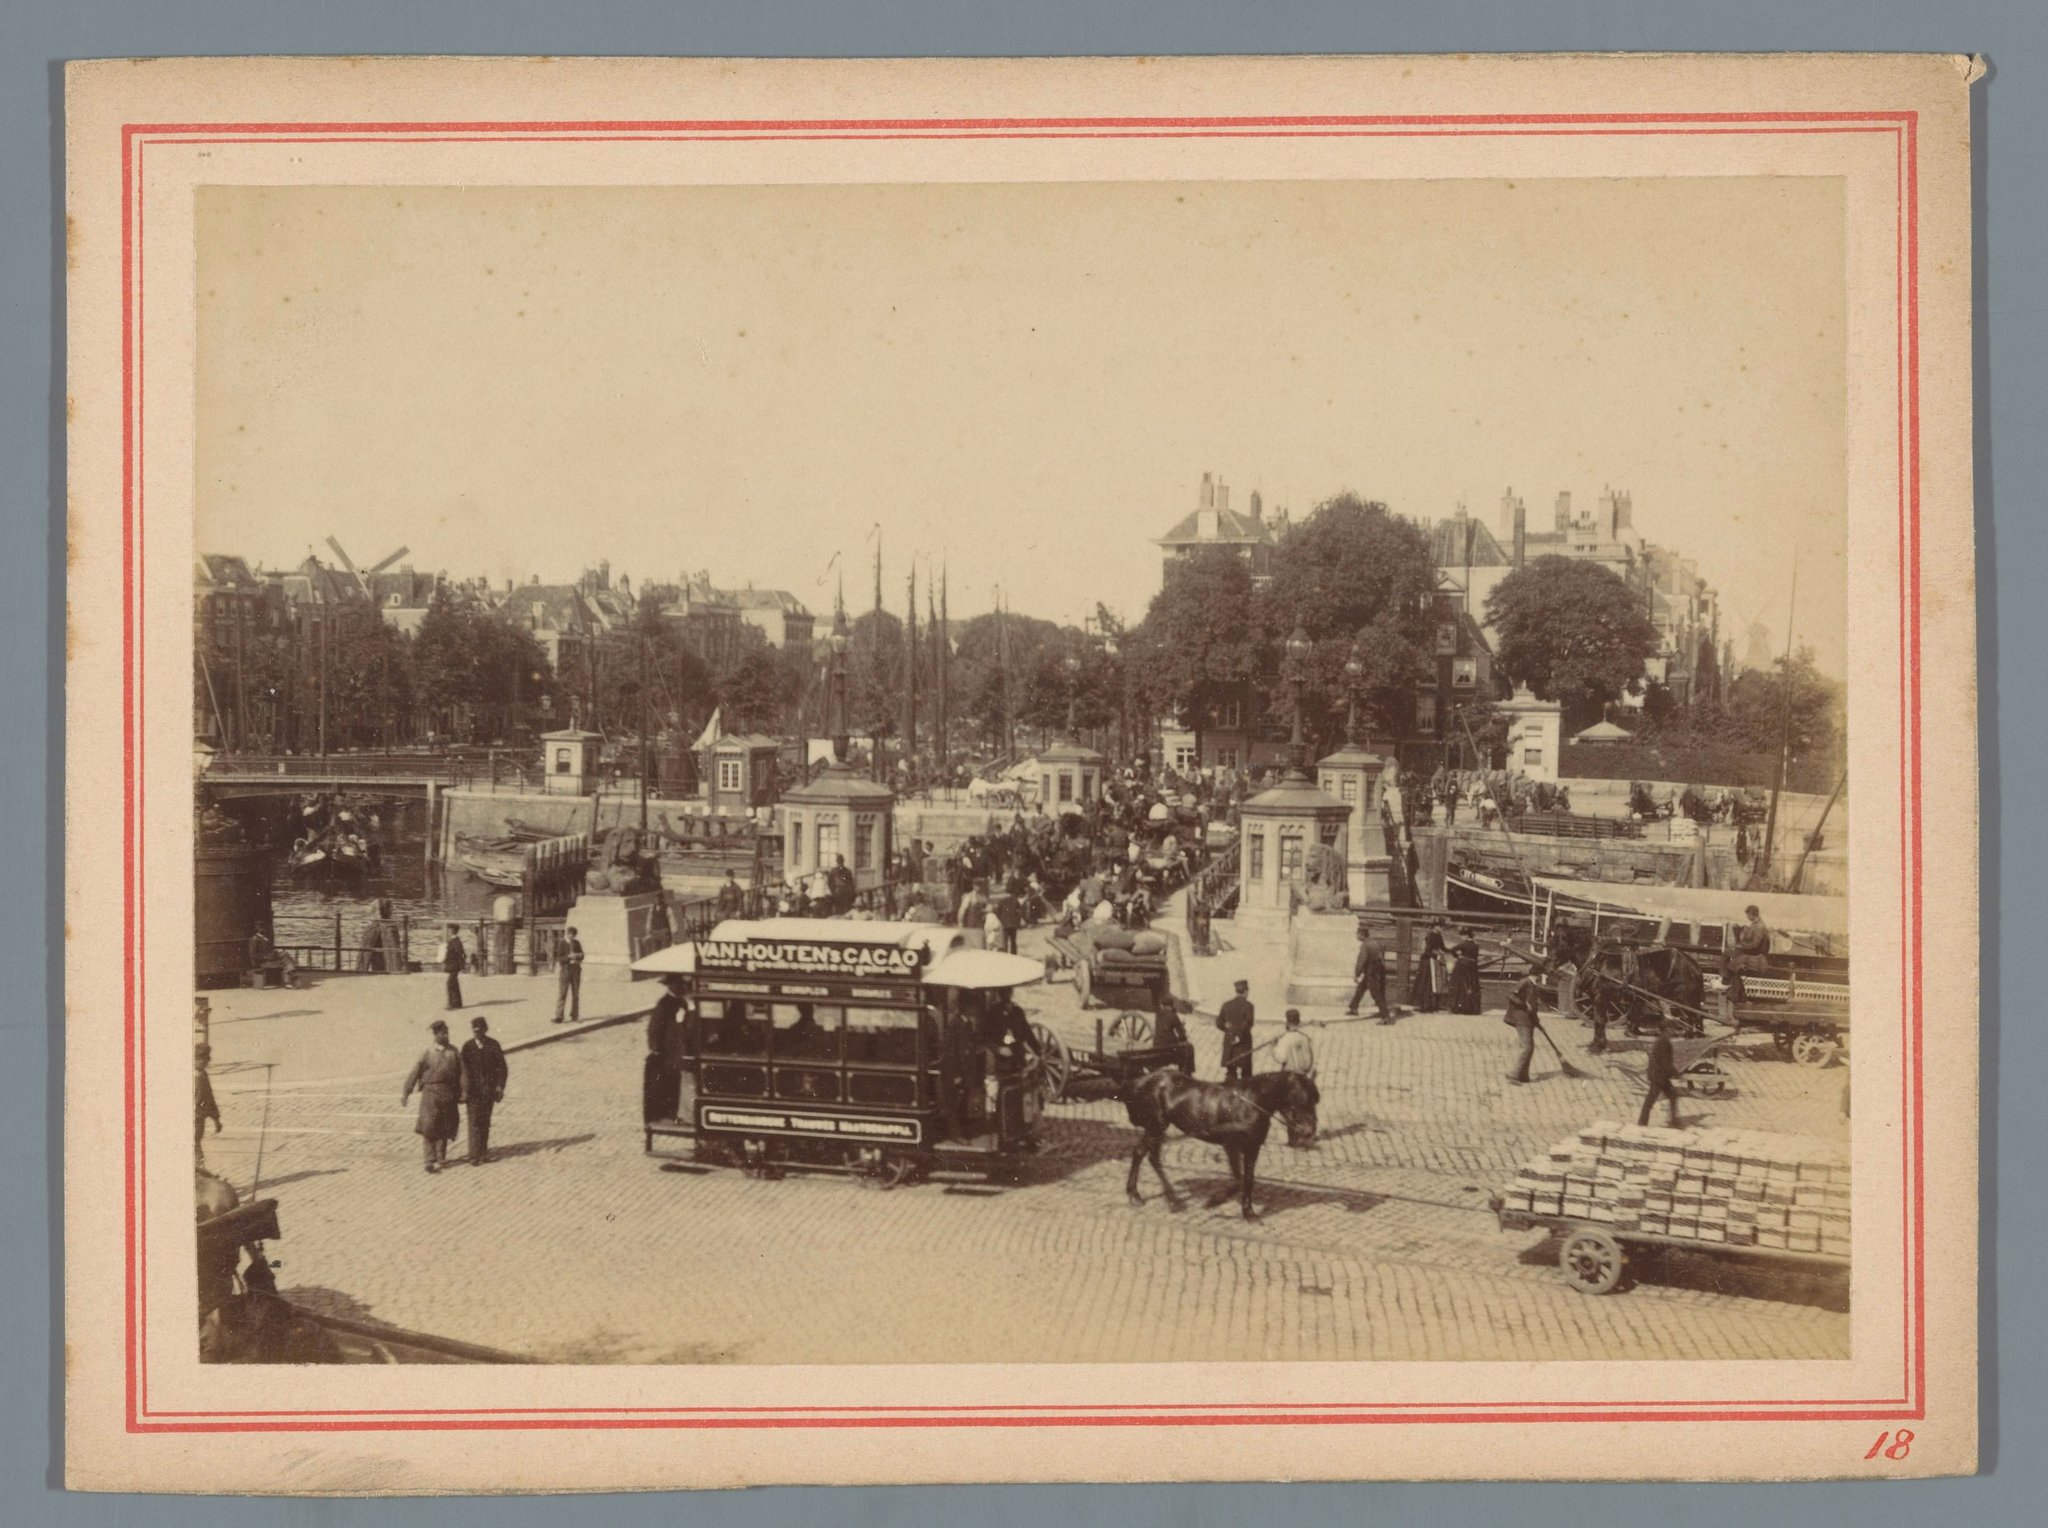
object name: cabinet photograph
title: Gezicht op de Koningsbrug te Rotterdam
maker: Anonymous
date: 1879-1900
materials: cardboard, photographic support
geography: rotterdam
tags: diligence, omnibus, horse-tram, city-view in general; 'veduta', bridge in city across river, canal, etc., rotterdam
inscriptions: inscription: ‘Rotterdam/ Koningsbrug’, number: ‘18’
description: De Koningsbrug werd op 24 september 1860 geopend door koning Willem III. De stenen leeuwen, ontworpen door Johannes Keerbergen, op sokkels geplaatst op de vier hoeken van de brug, waren afkomstig van de in 1833 afgebroken Hofpoort uit 1778.